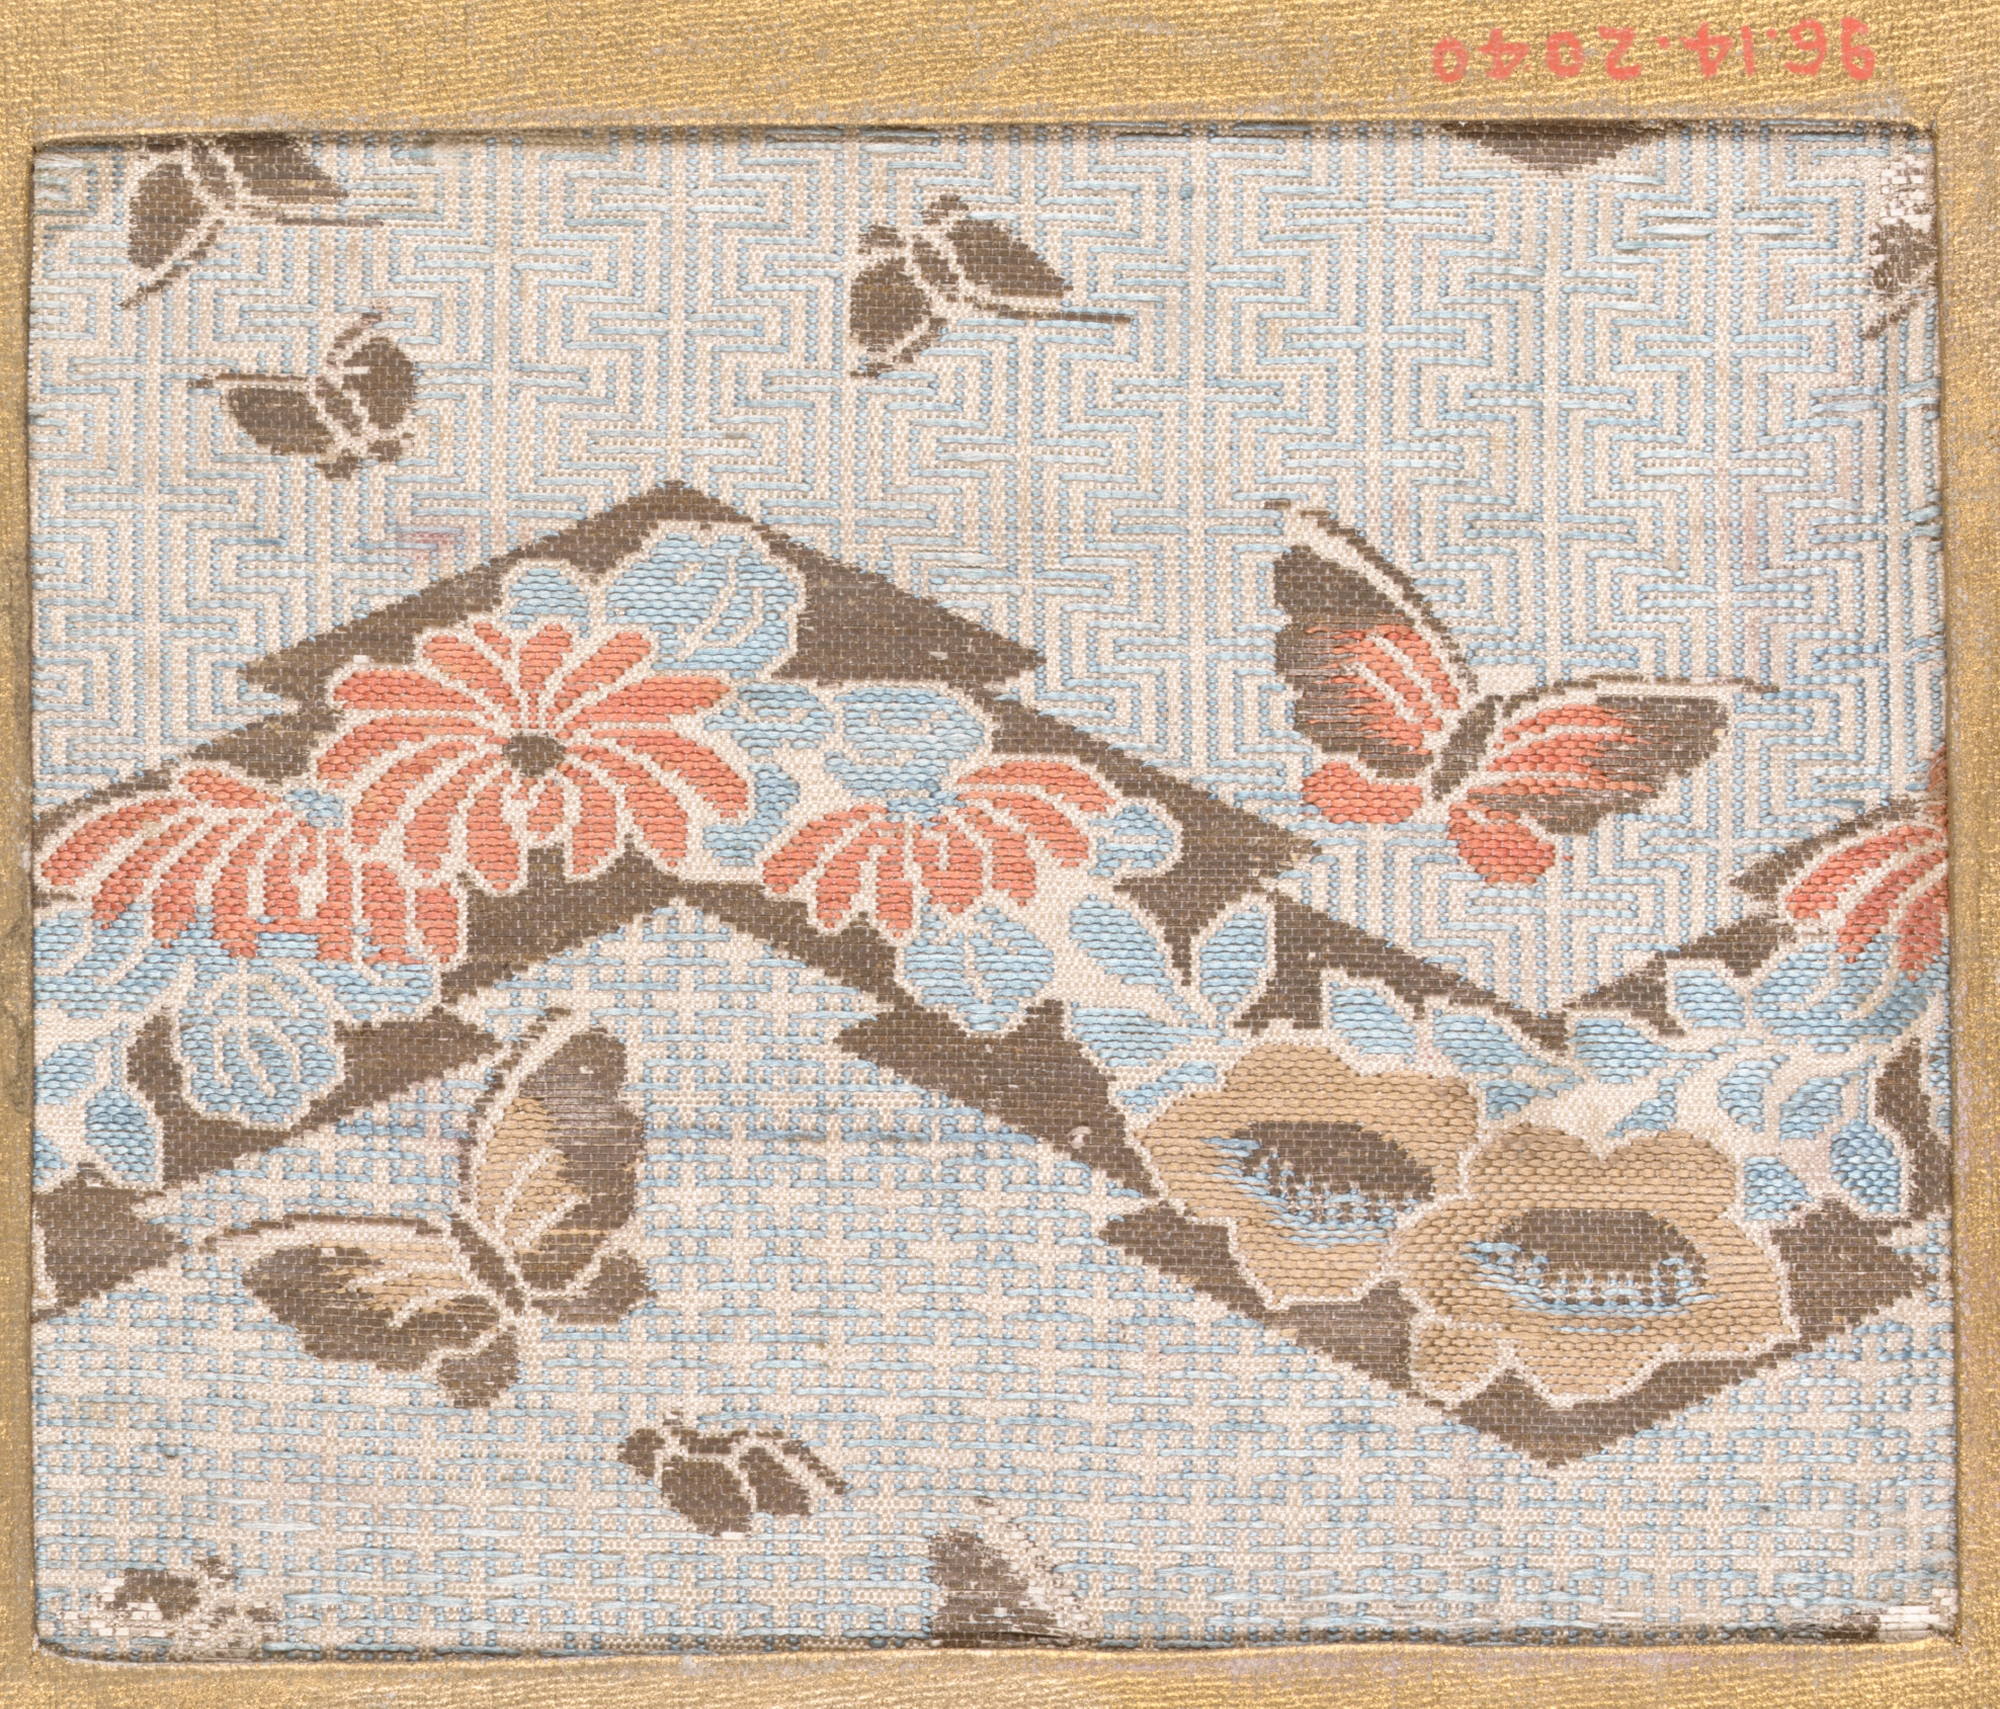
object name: piece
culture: japanese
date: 1701-1900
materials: silk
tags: butterflies